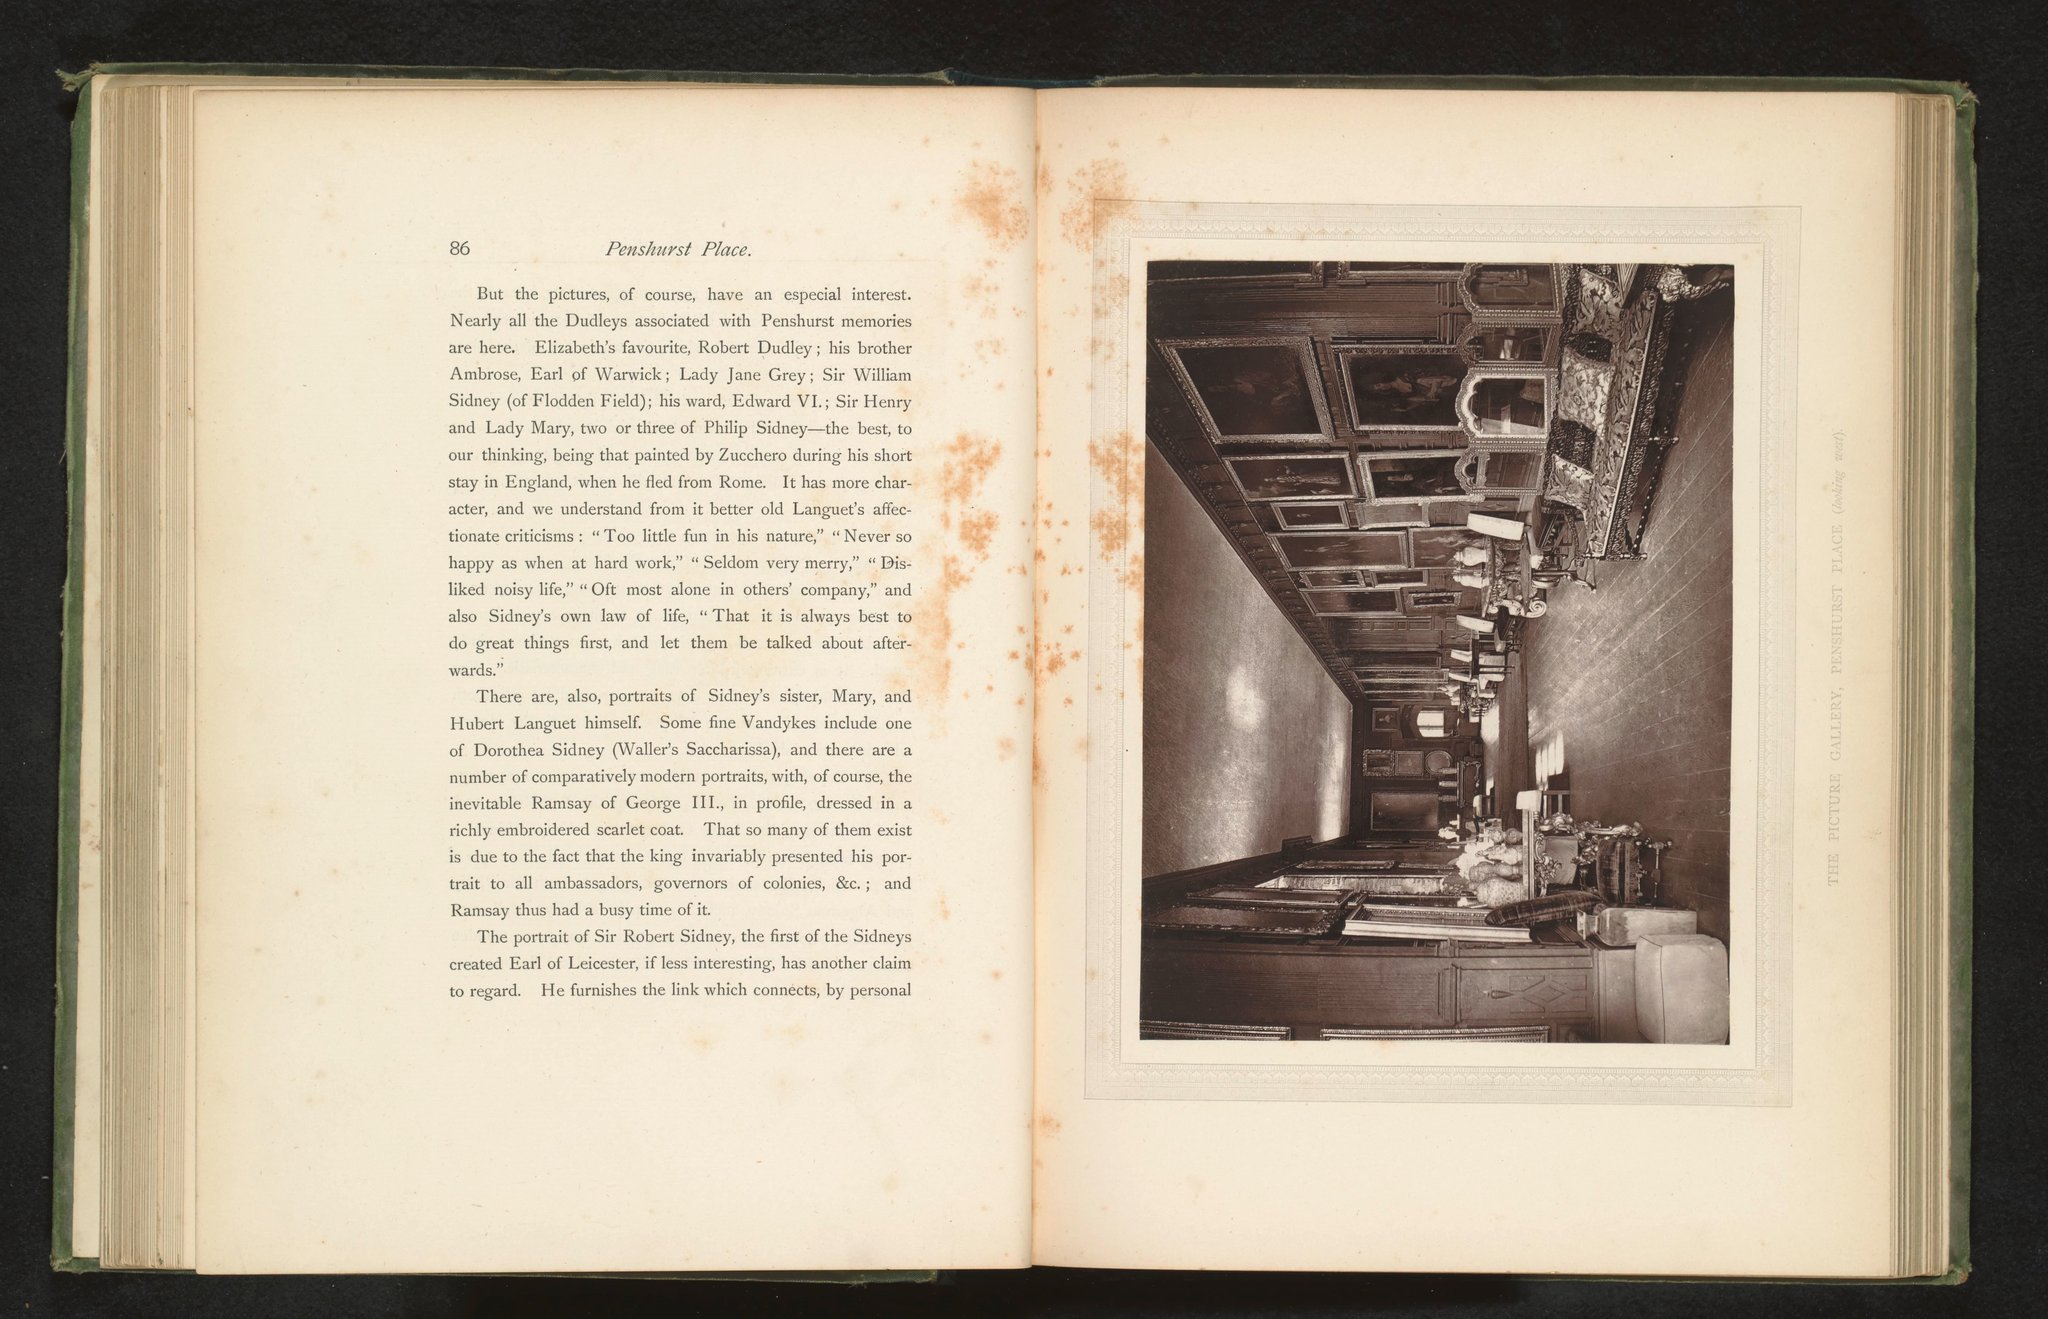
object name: page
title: The picture gallery, Penshurst Place (looking west)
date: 1866-1876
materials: paper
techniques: woodburytype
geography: penshurst place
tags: art collection, art gallery, interior of the house